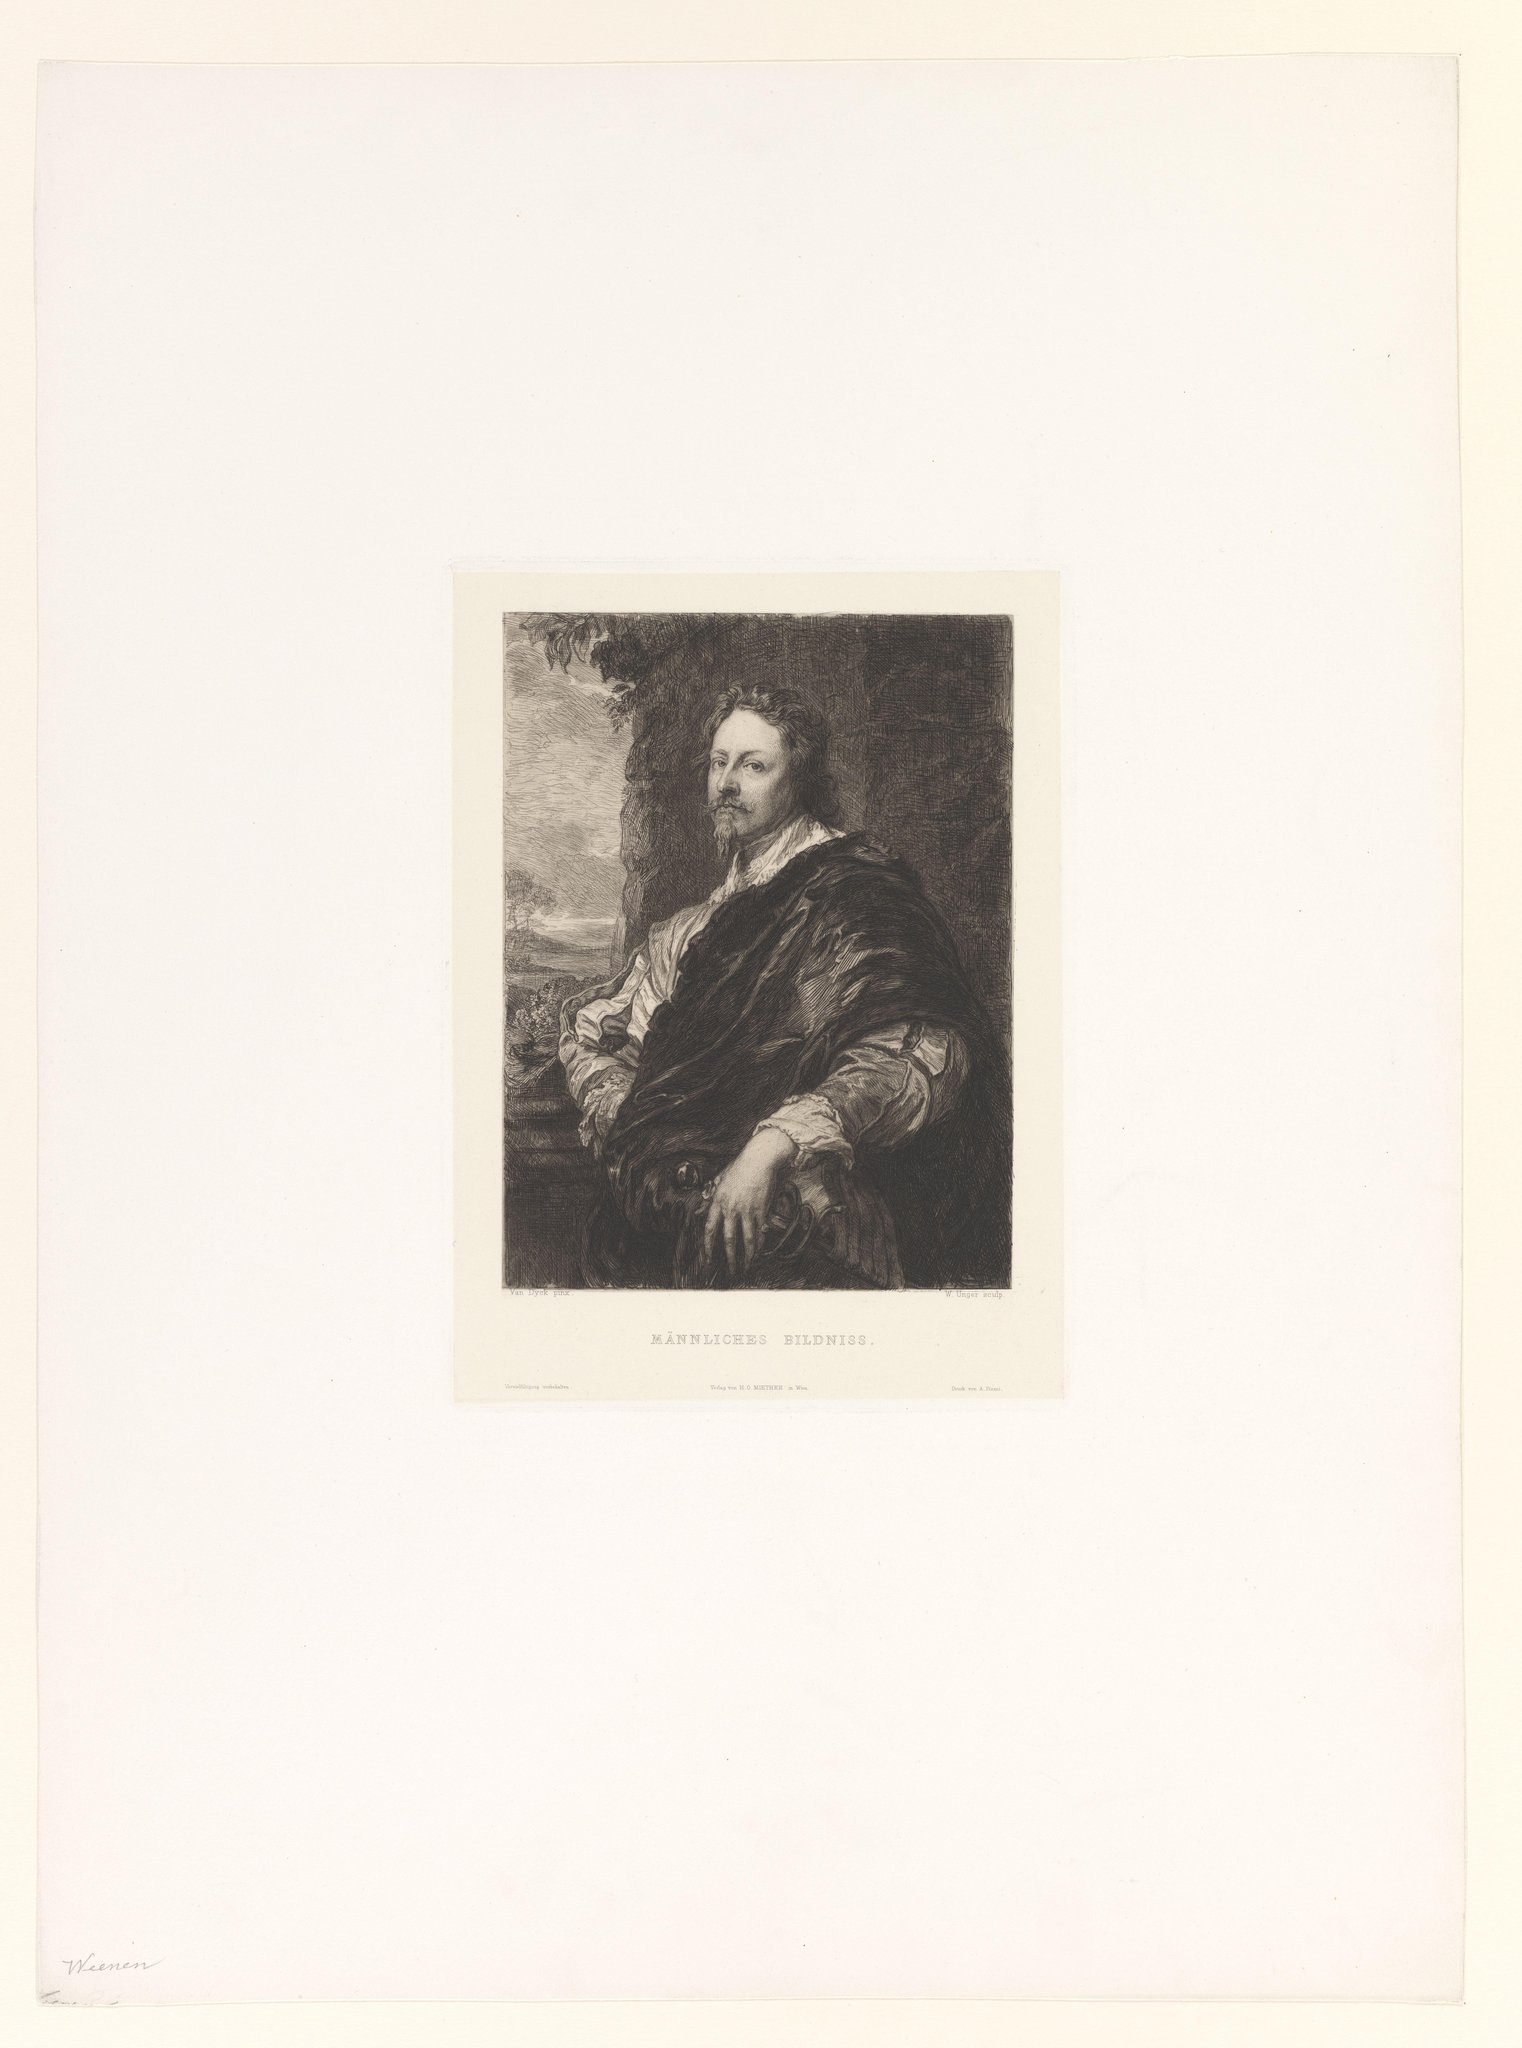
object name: print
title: Männliches Bildniss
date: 1861-1889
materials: paper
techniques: etching, intaglio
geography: vienna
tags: london, historical persons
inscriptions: collector's mark: Lugt 2228